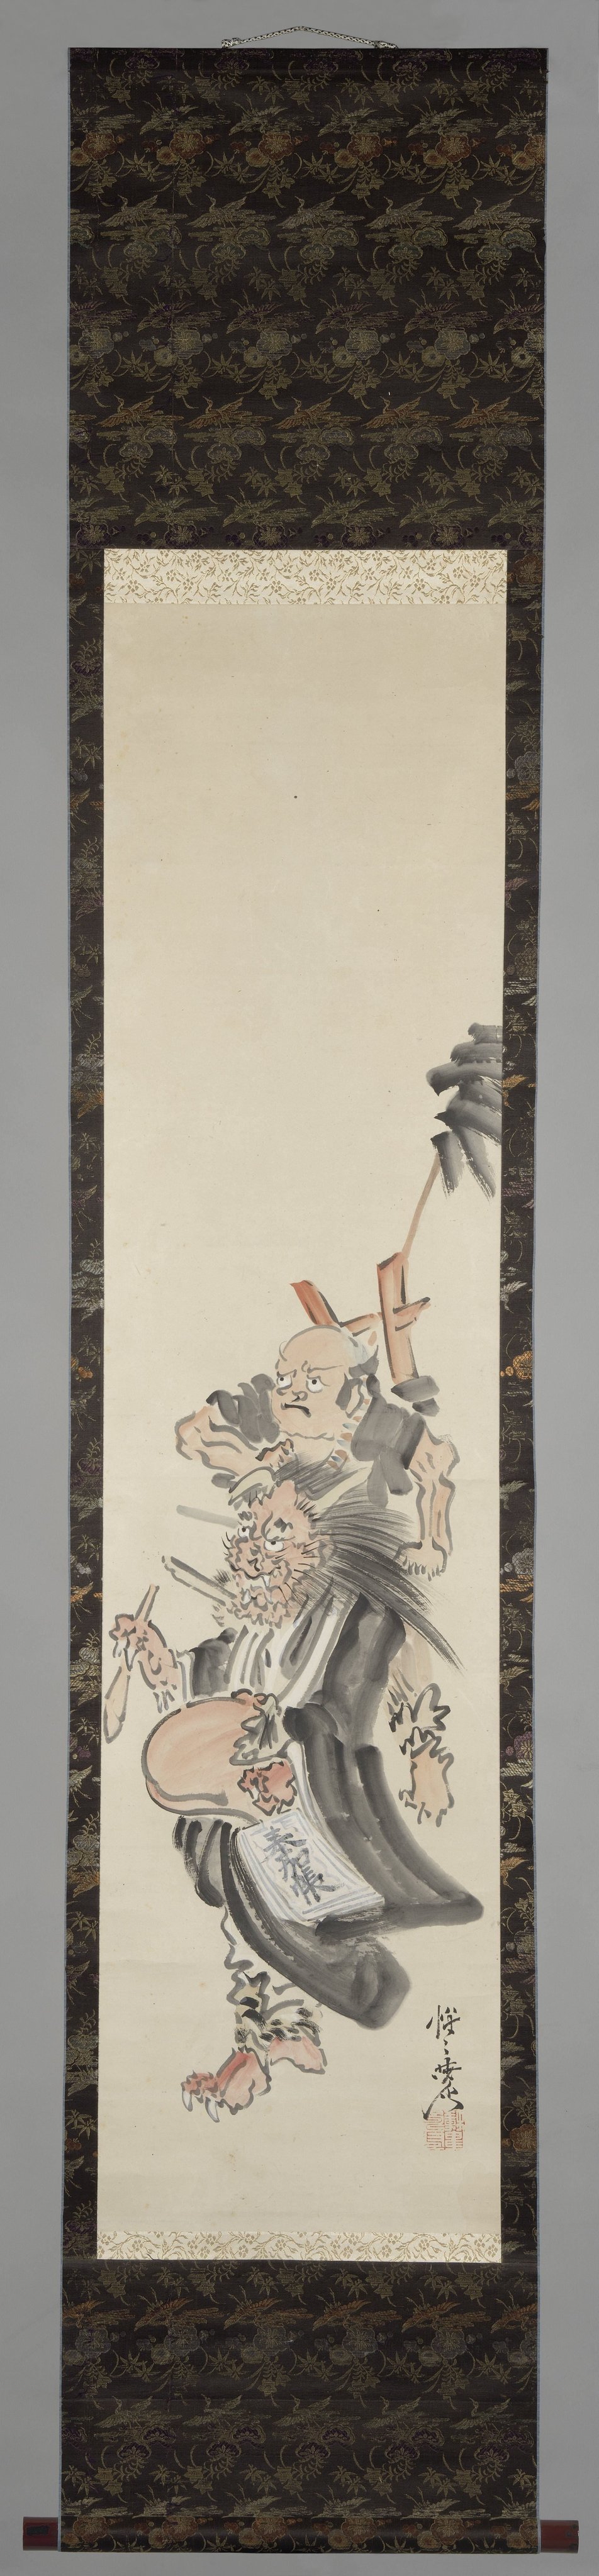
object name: hanging scroll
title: A demon as a mendicant monk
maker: kawanabe kyôsai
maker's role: draughtsman, print maker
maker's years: 1831-1889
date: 1850-1889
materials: ink, paper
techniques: painted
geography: japan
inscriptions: signature: ‘Shojo Kyosai’, seal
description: A demon dressed as a mendicant monk is travelling to collect money for a temple, while calling on Buddha Amida in a loud voice. He is striking a wooden gong to announce his arrival. The motif is a metaphor for Buddhism’s power to save: even demons can change their ways. Although this depiction is probably an ironic portrayal of insincerity and pretended piety.